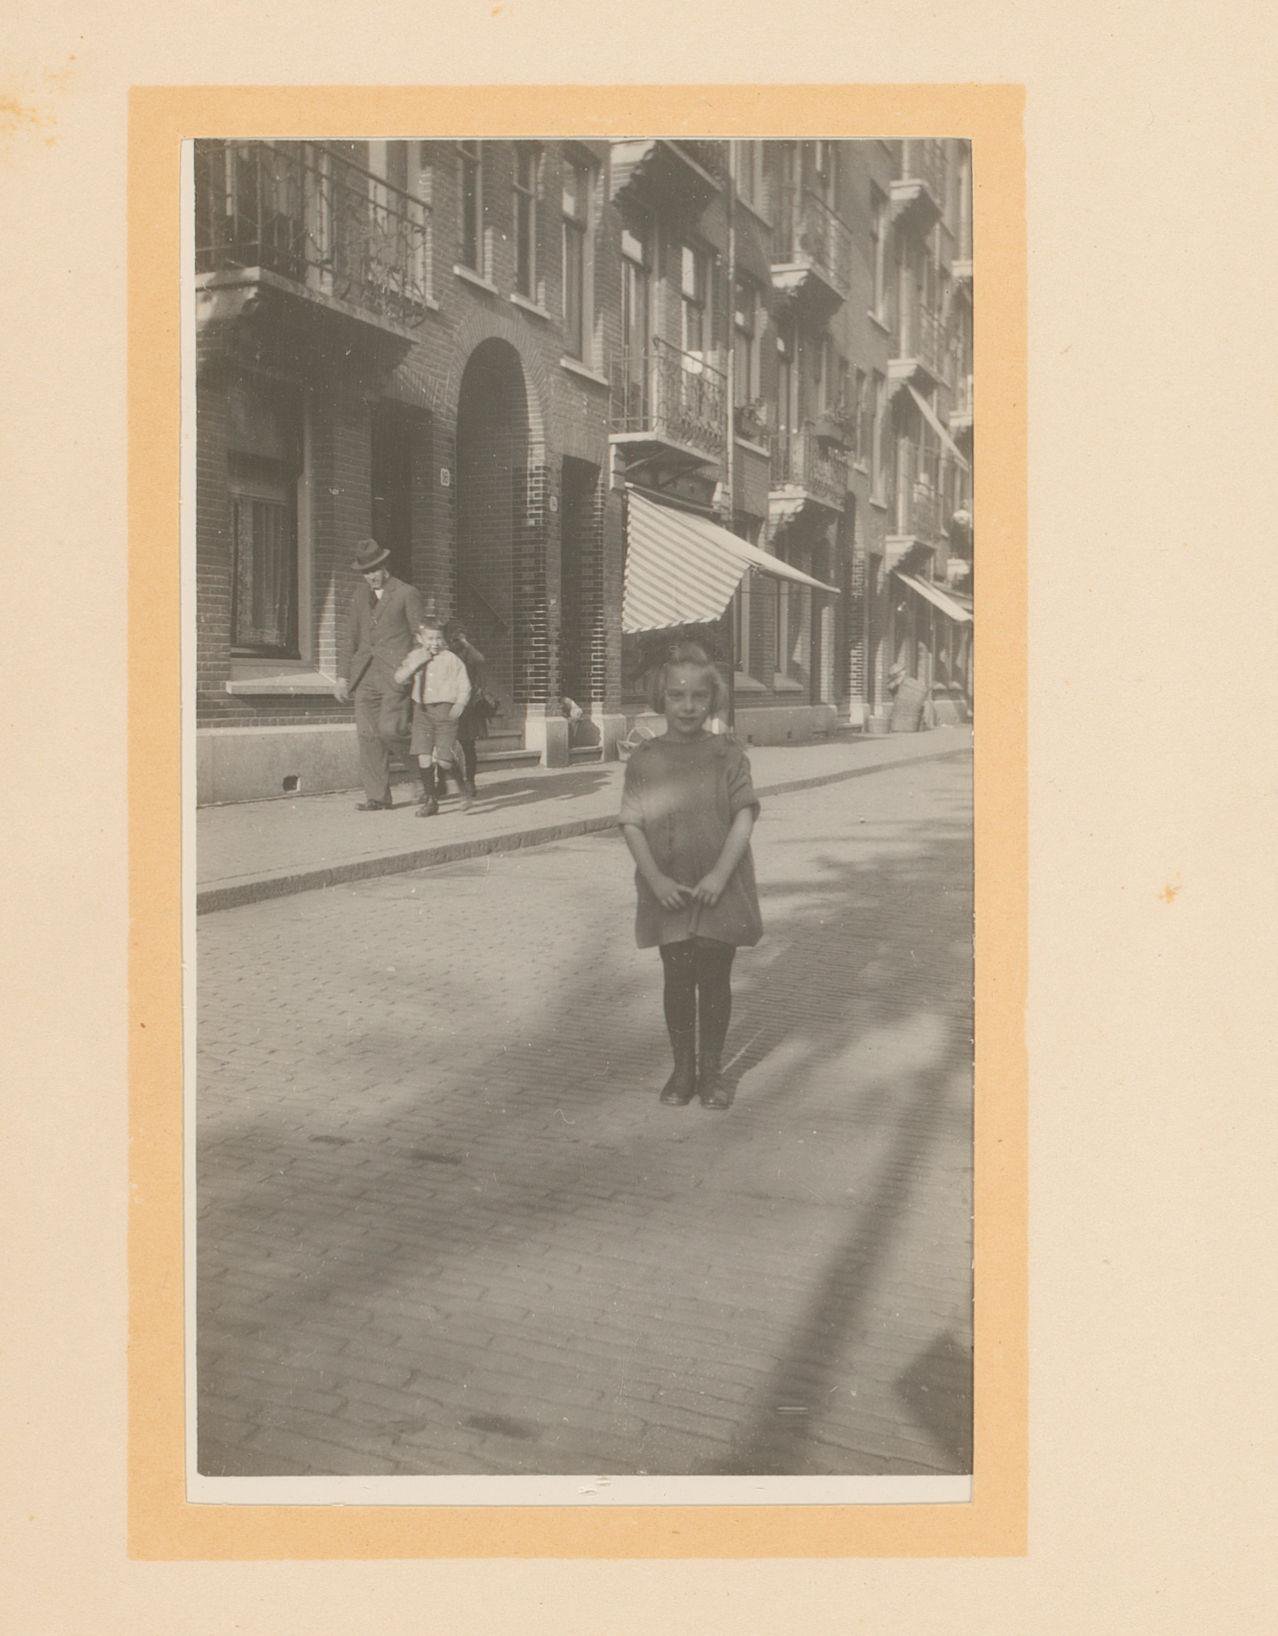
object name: photograph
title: Straatgezicht in een Nederlandse stad, op de voorgrond de schaduw van de fotograaf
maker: Anonymous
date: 1927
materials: paper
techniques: gelatin silver print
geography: netherlands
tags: street, netherlands